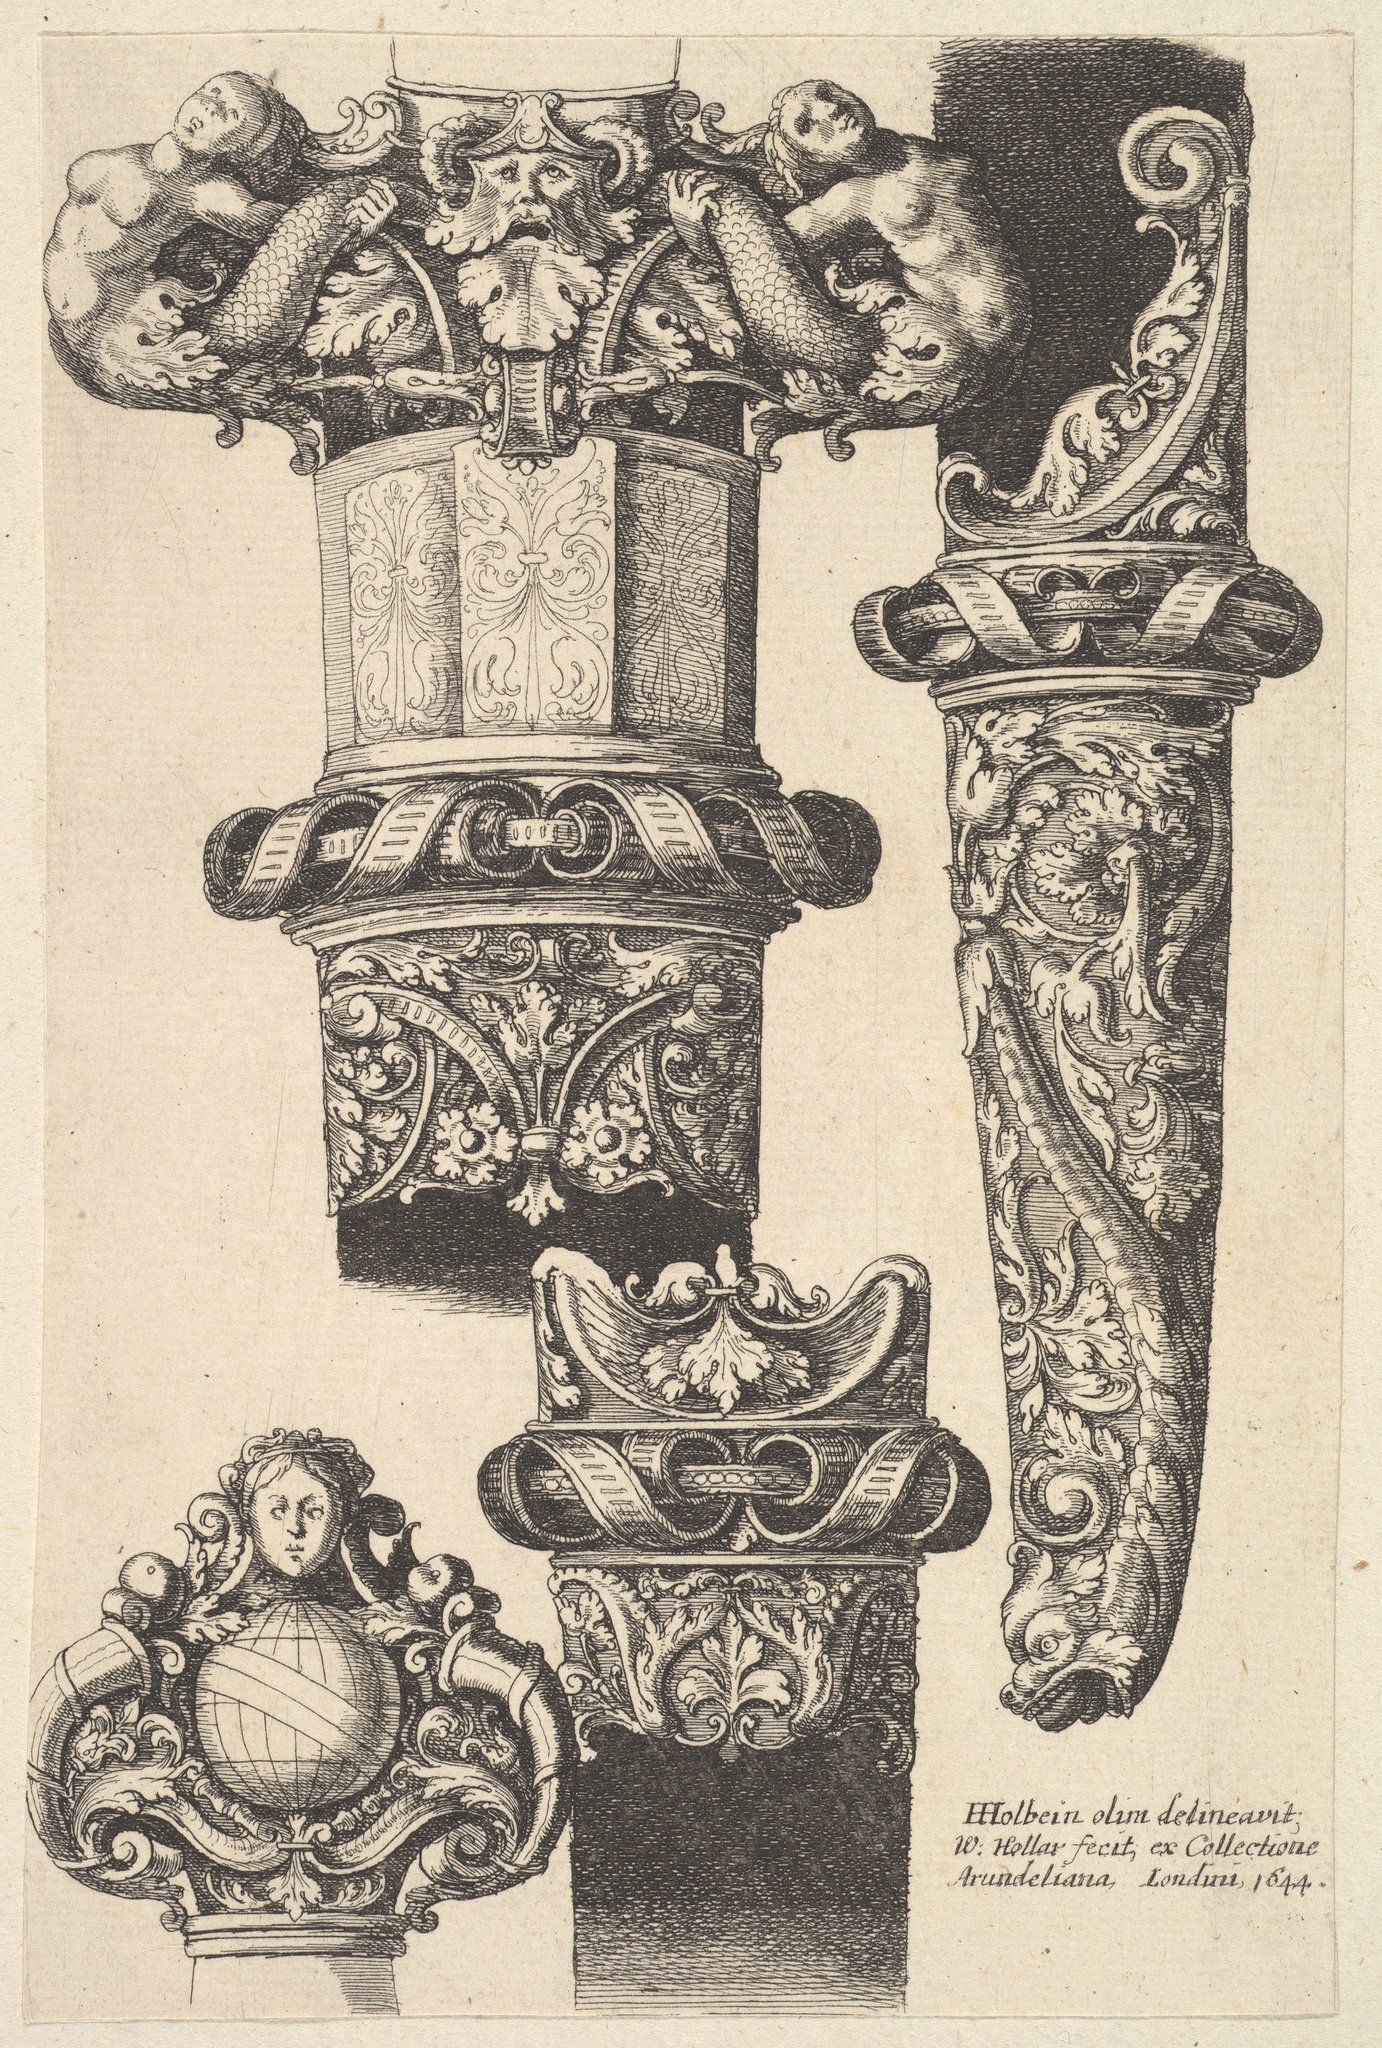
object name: print ornament architecture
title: Daggars and scabbards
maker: wenceslaus hollar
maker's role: artist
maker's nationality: bohemian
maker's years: 1607-1677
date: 1644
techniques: etching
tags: daggers,ornament,faces,flowers